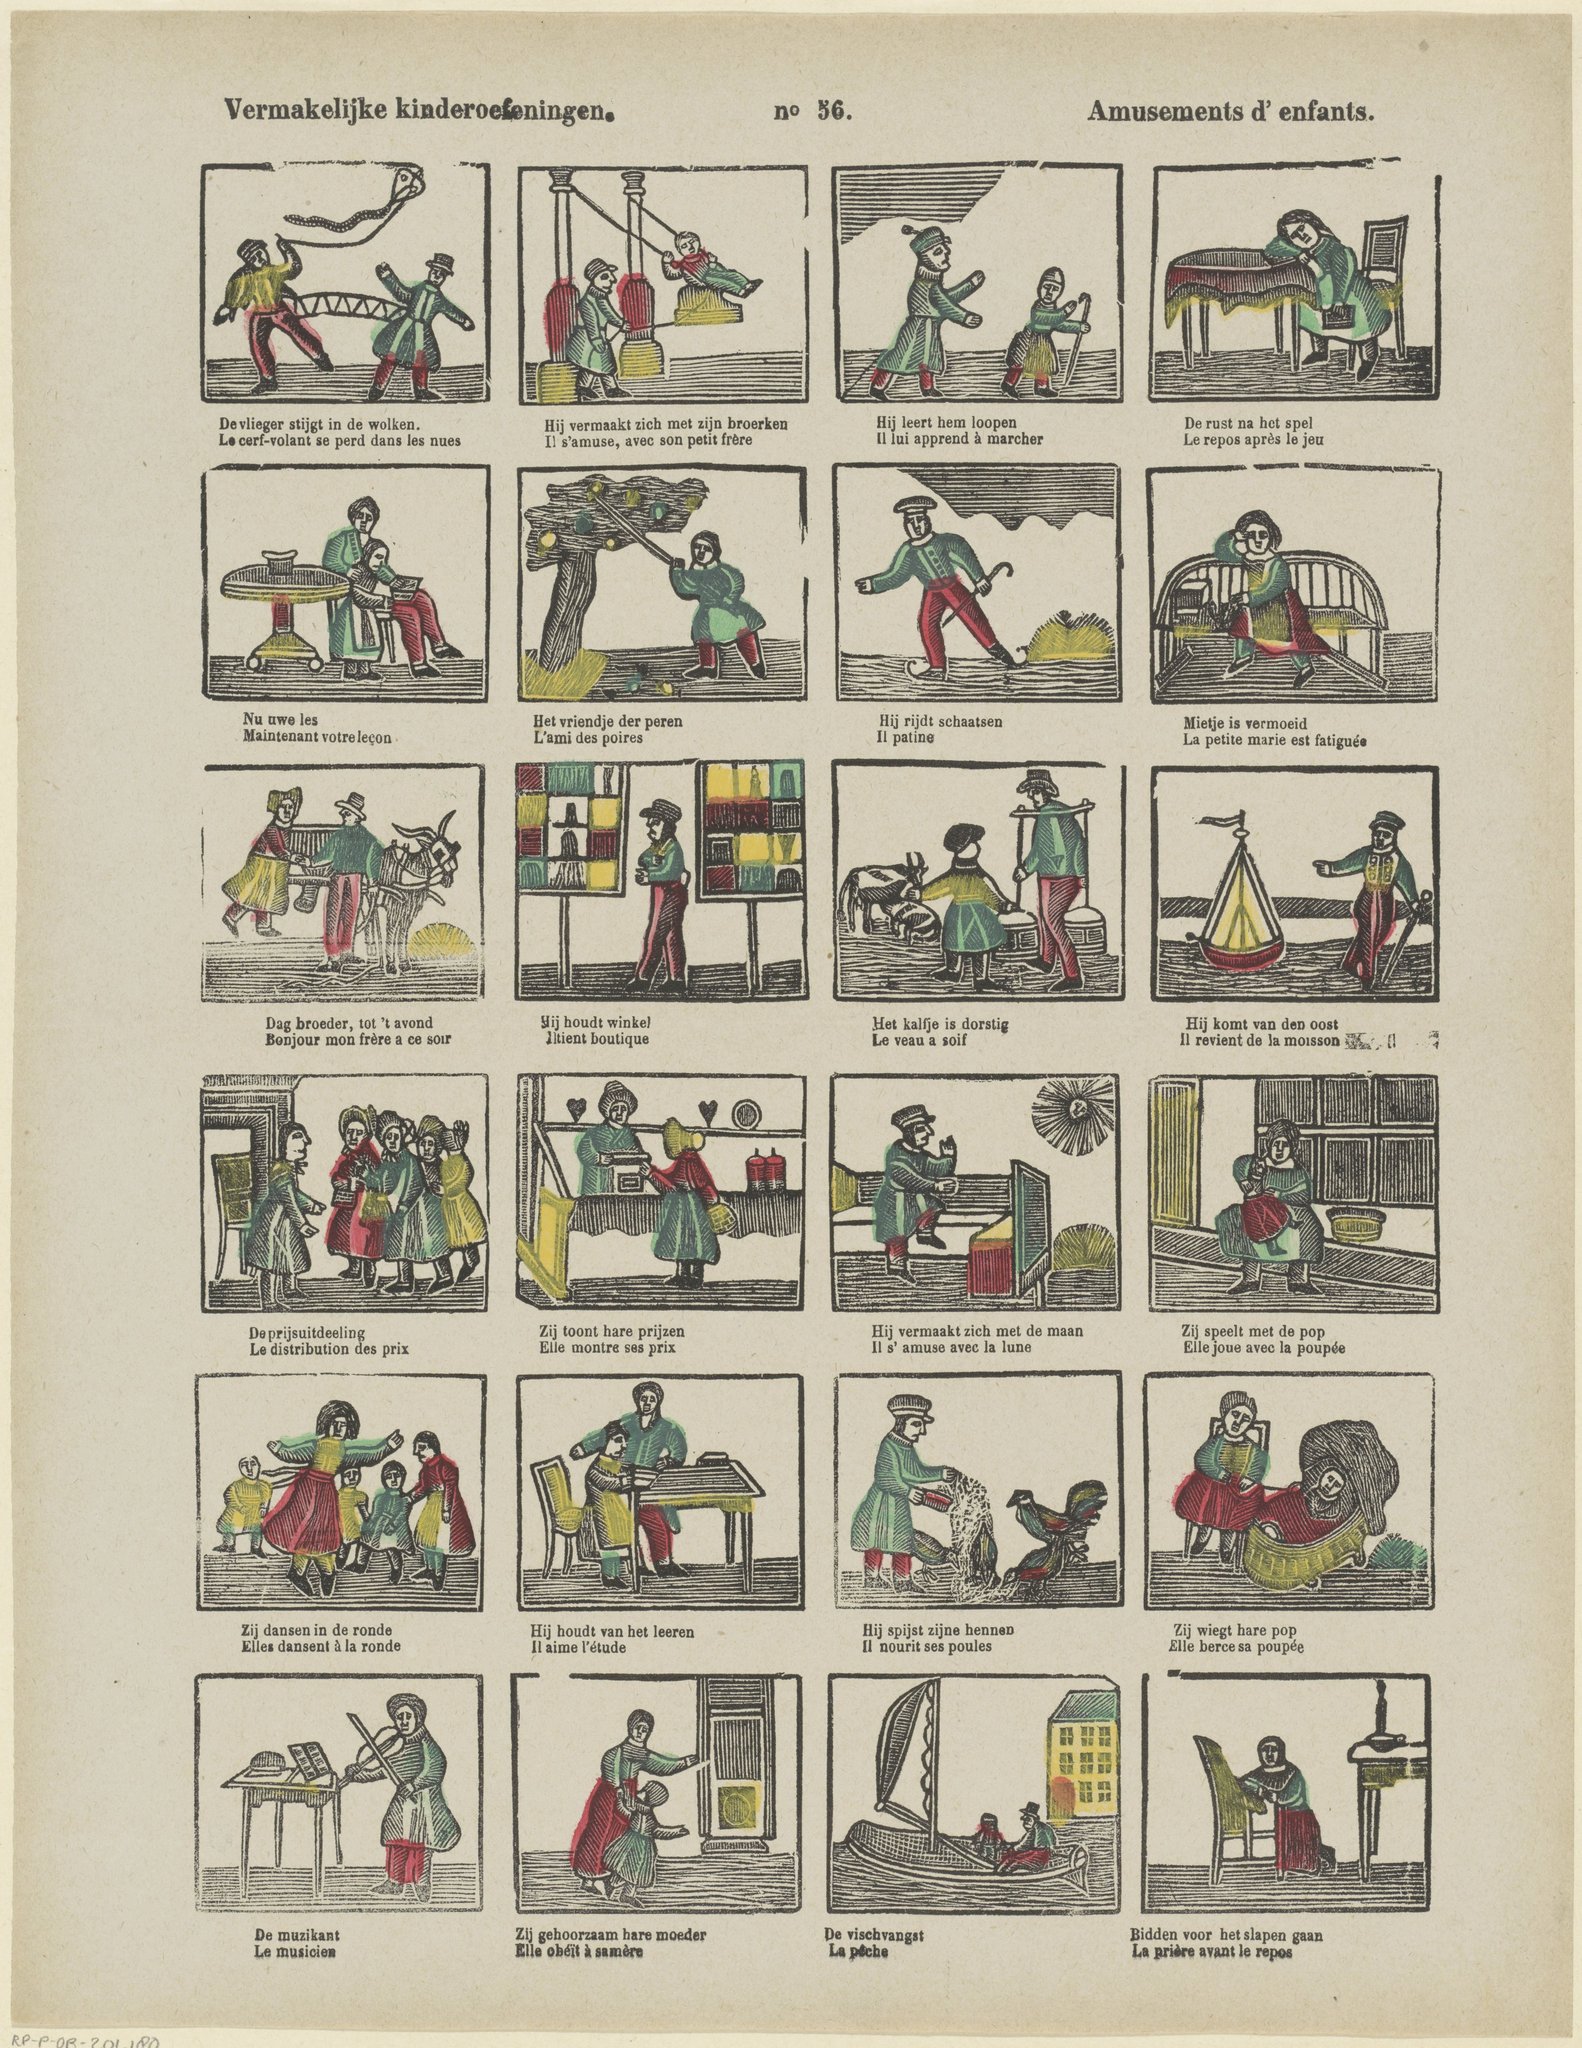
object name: popular print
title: Vermakelijke kinderoefeningen / Amusements d' enfants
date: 1866-1902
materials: paper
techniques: colour, letterpress printing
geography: turnhout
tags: children's games and plays, child, swinging (children's game)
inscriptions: collector's mark: Lugt 2760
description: Blad met 24 voorstellingen van kinderspelen en bezigheden, zoals schommelen, leren lopen, dansen en bidden voor het slapengaan. Onder elke voorstelling een onderschrift in het Nederlands en het Frans. Genummerd midden boven: no 56.